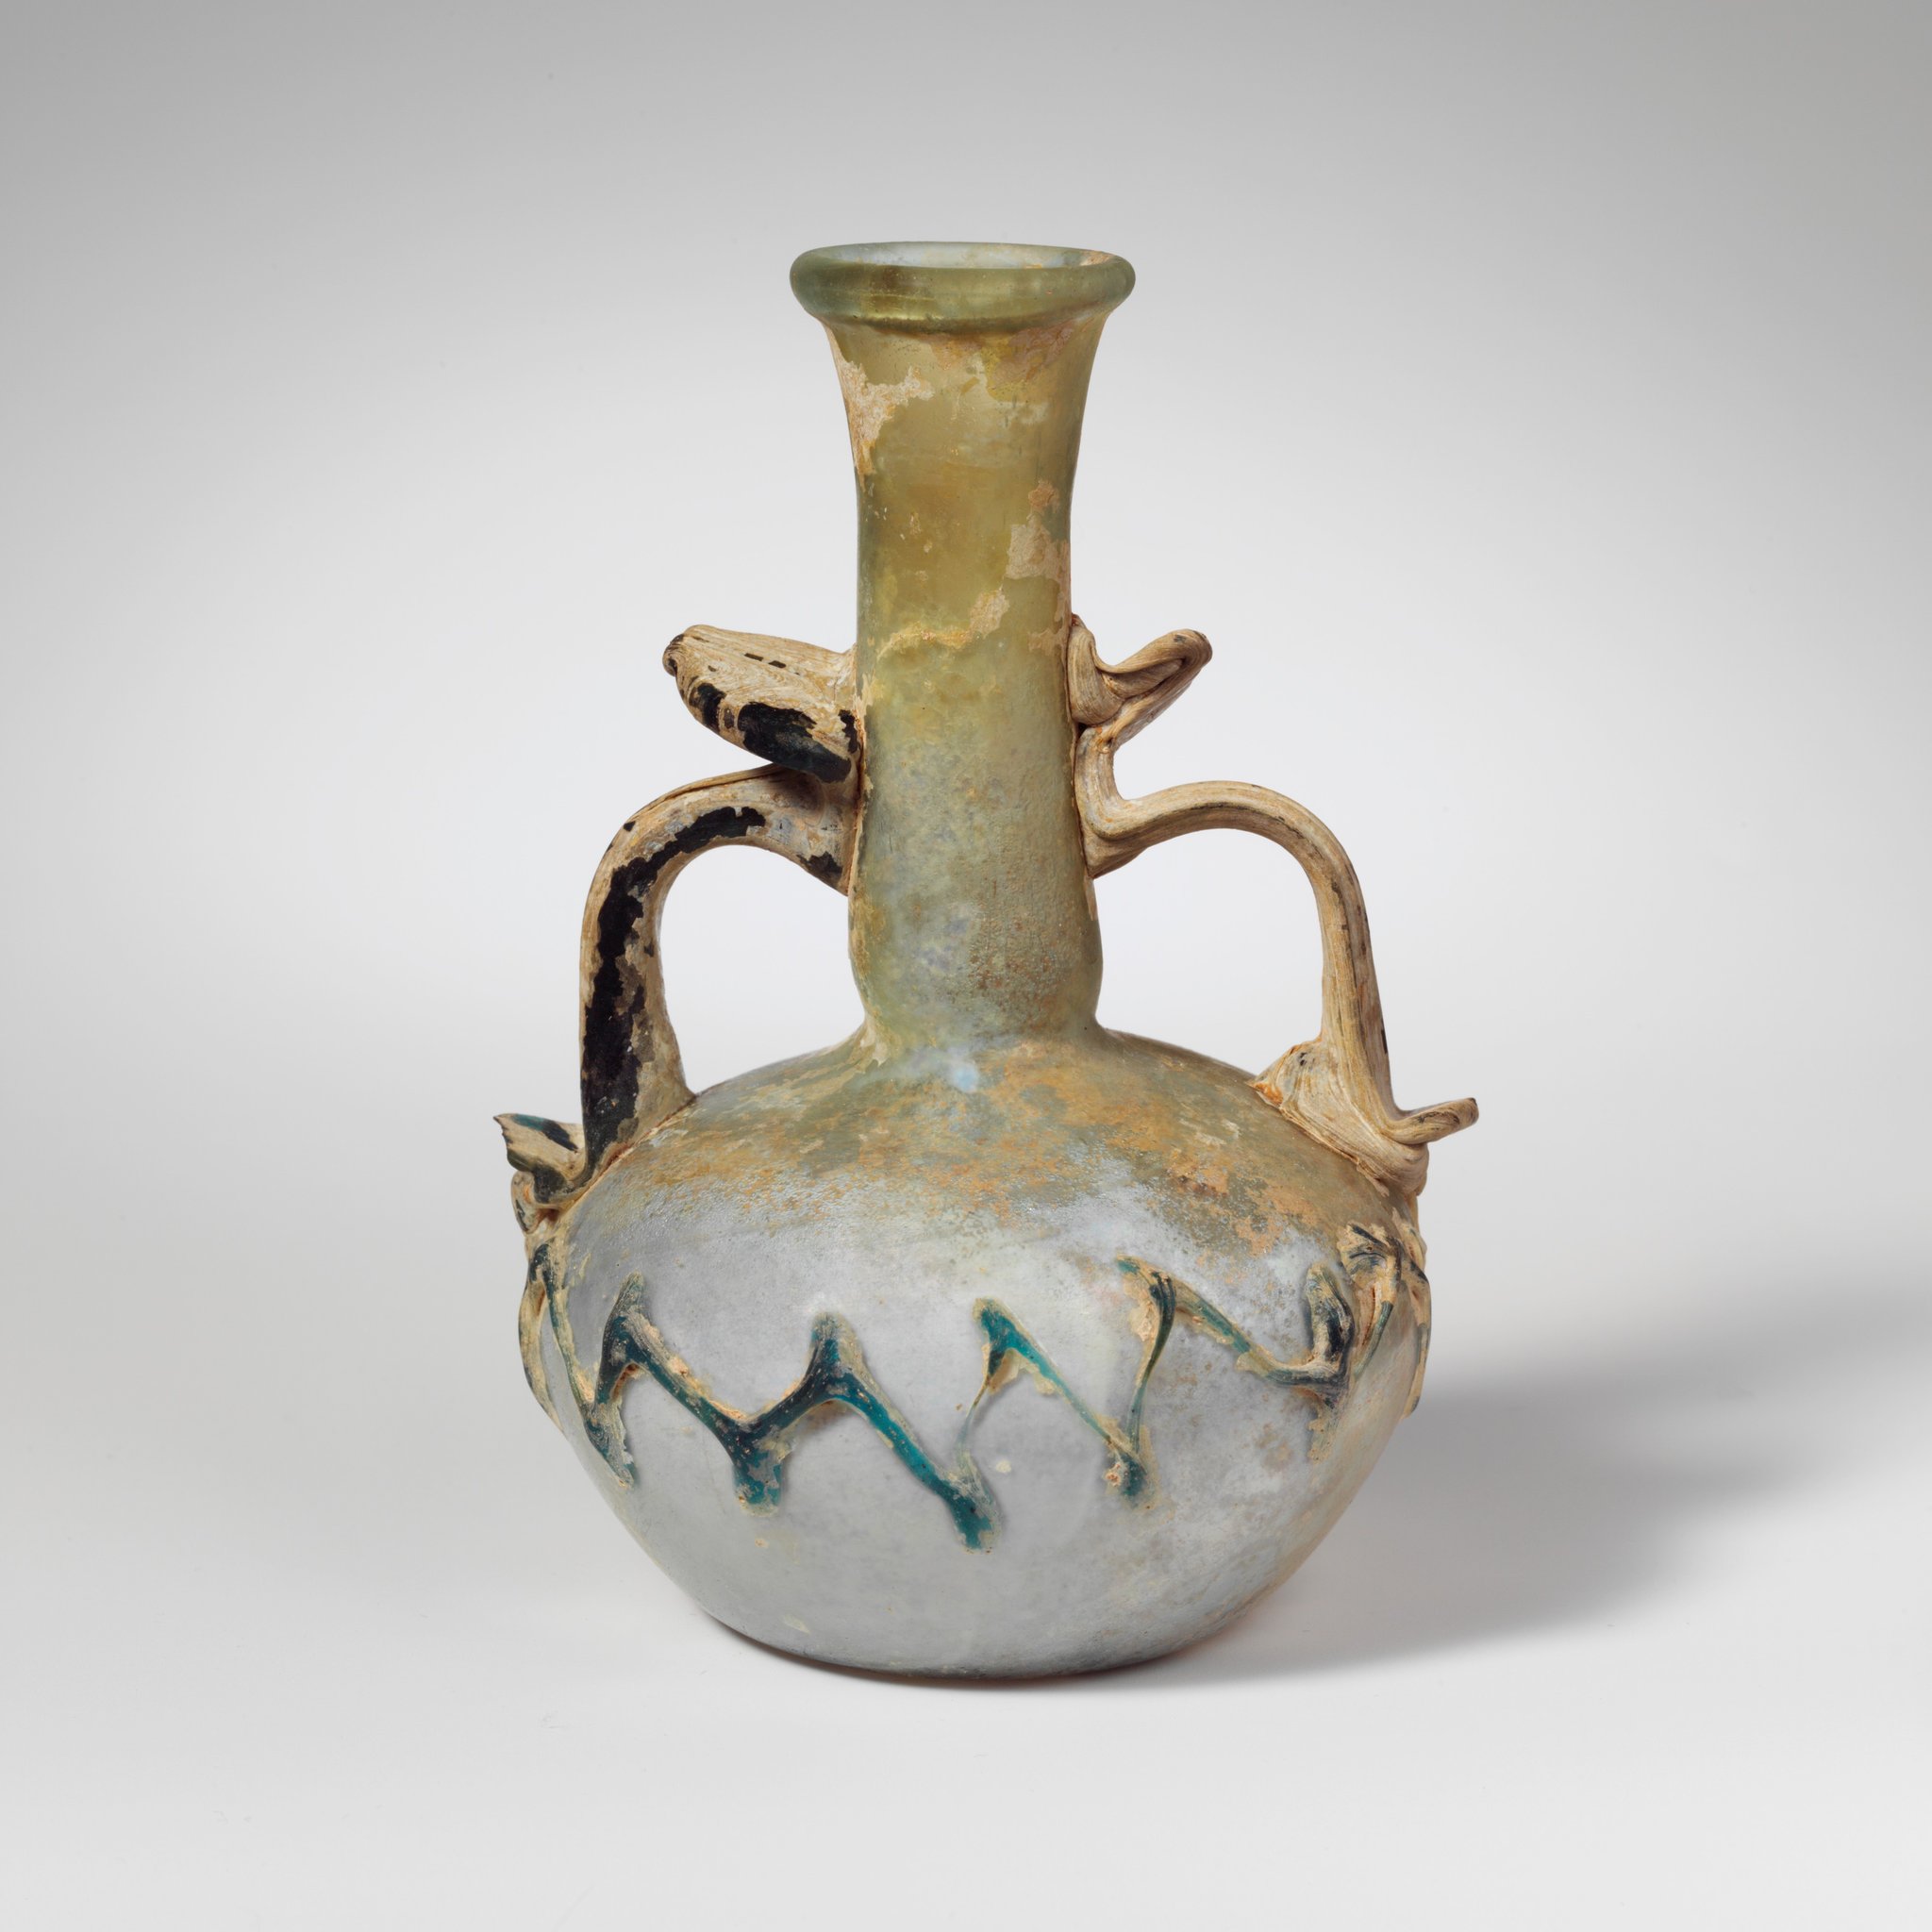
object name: bottle, two handled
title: Glass two-handled bottle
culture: roman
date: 301-500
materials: glass